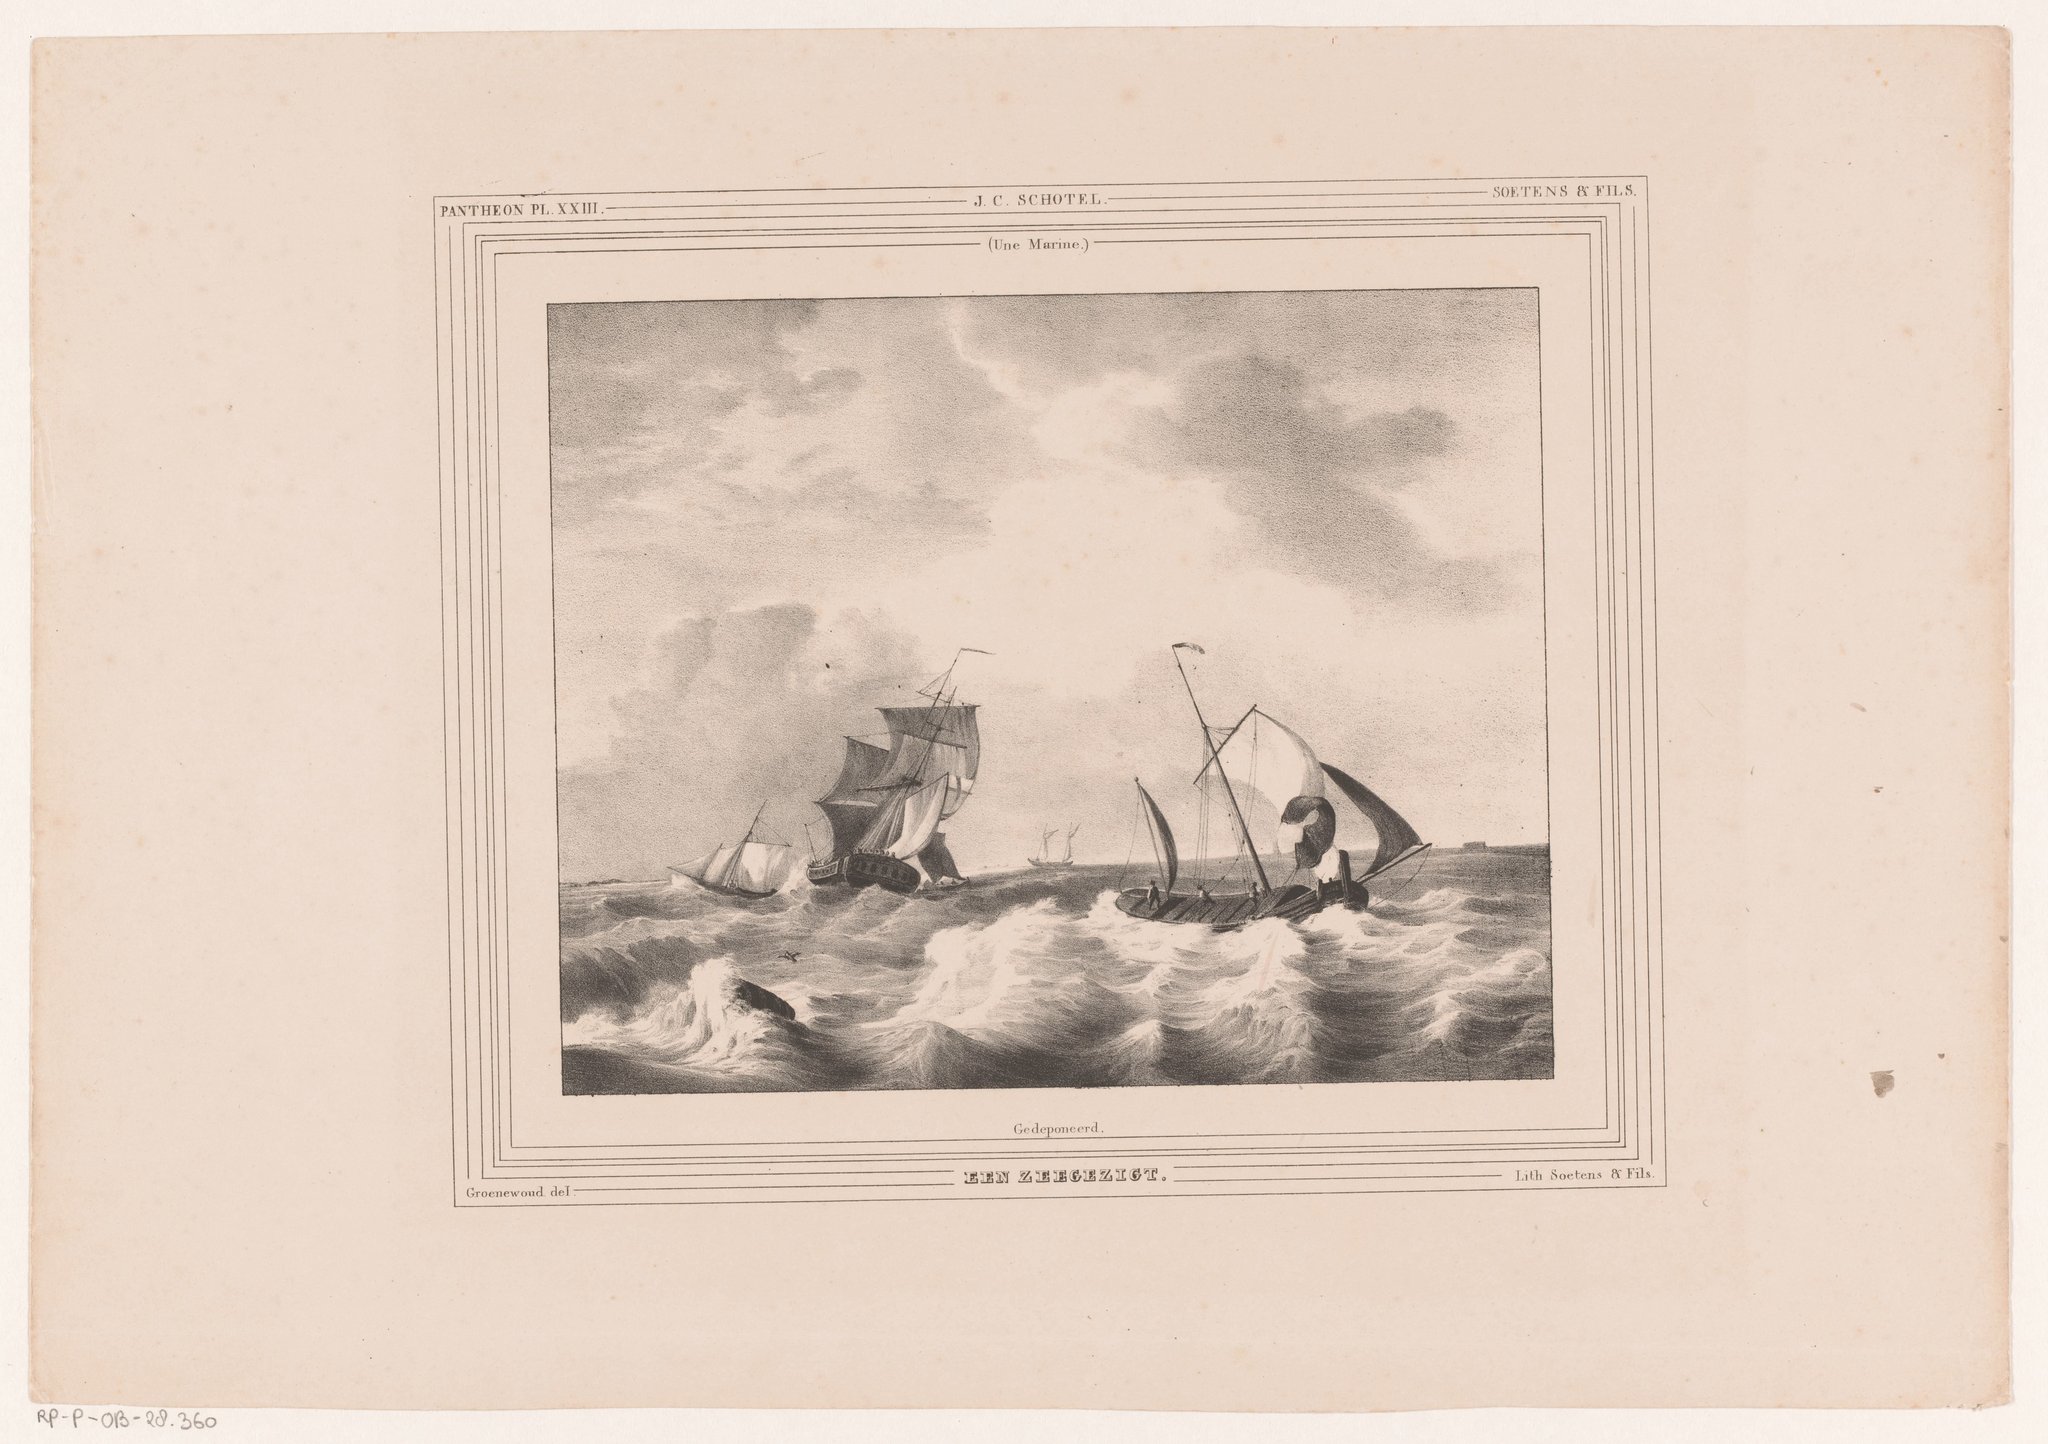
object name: print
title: Een Zeegezigt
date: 1837-1840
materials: paper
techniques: lithograph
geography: the hague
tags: sailing-ship, sailing-boat, sea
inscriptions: collector's mark: Lugt 2228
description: De zee is onrustig en de boten liggen schuin op de golven. Linksboven: Pantheon Pl. XXIII.